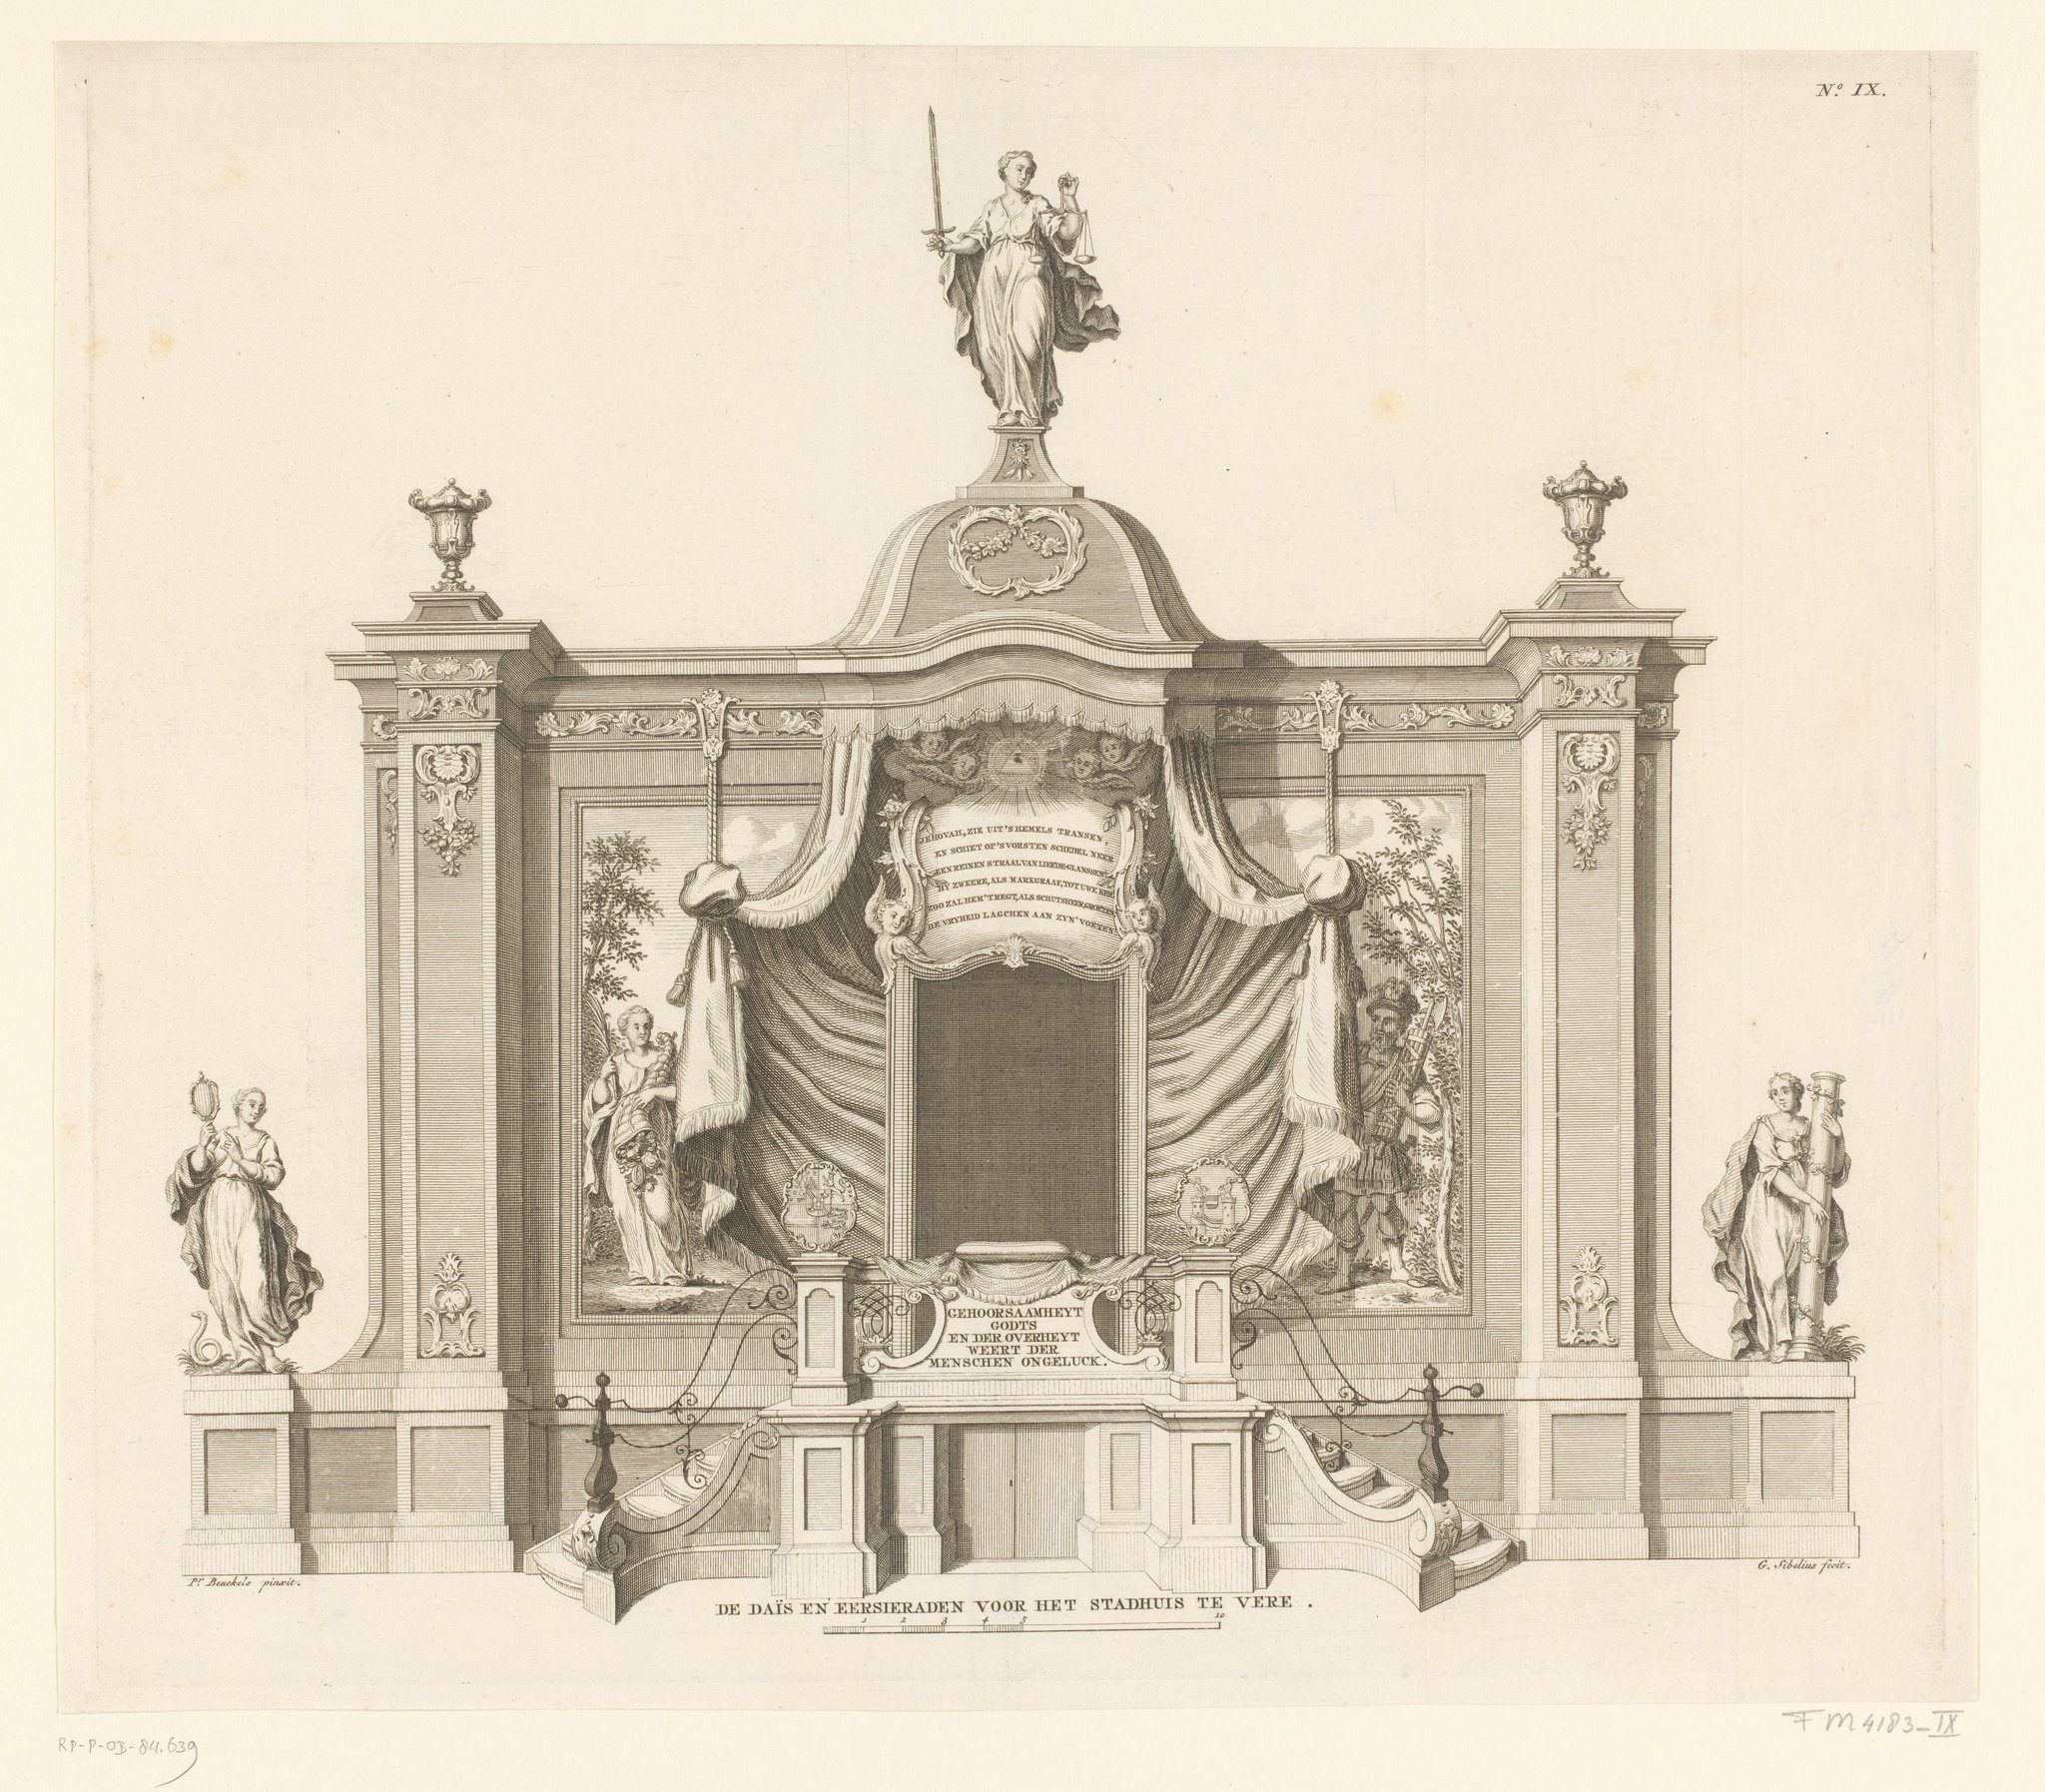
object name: print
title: Erepoort bij de intocht van Willem V te Veere (Nr. IX), 1766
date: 1766-1767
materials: paper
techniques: engraving, etching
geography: northern netherlands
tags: the hague, william v (prince of orange), triumphal arch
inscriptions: collector's mark: Lugt 2228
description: Platform of verhoging opgericht voor het stadhuis te Veere, versierd met standbeelden van personificaties van deugden. Onderdeel van een groep van 10 platen van de decoraties te Veere ter gelegenheid van de inhuldiging van stadhouder Willem V als Markgraaf van Veere, 28 mei 1766. Genummerd rechtsboven: No. IX.